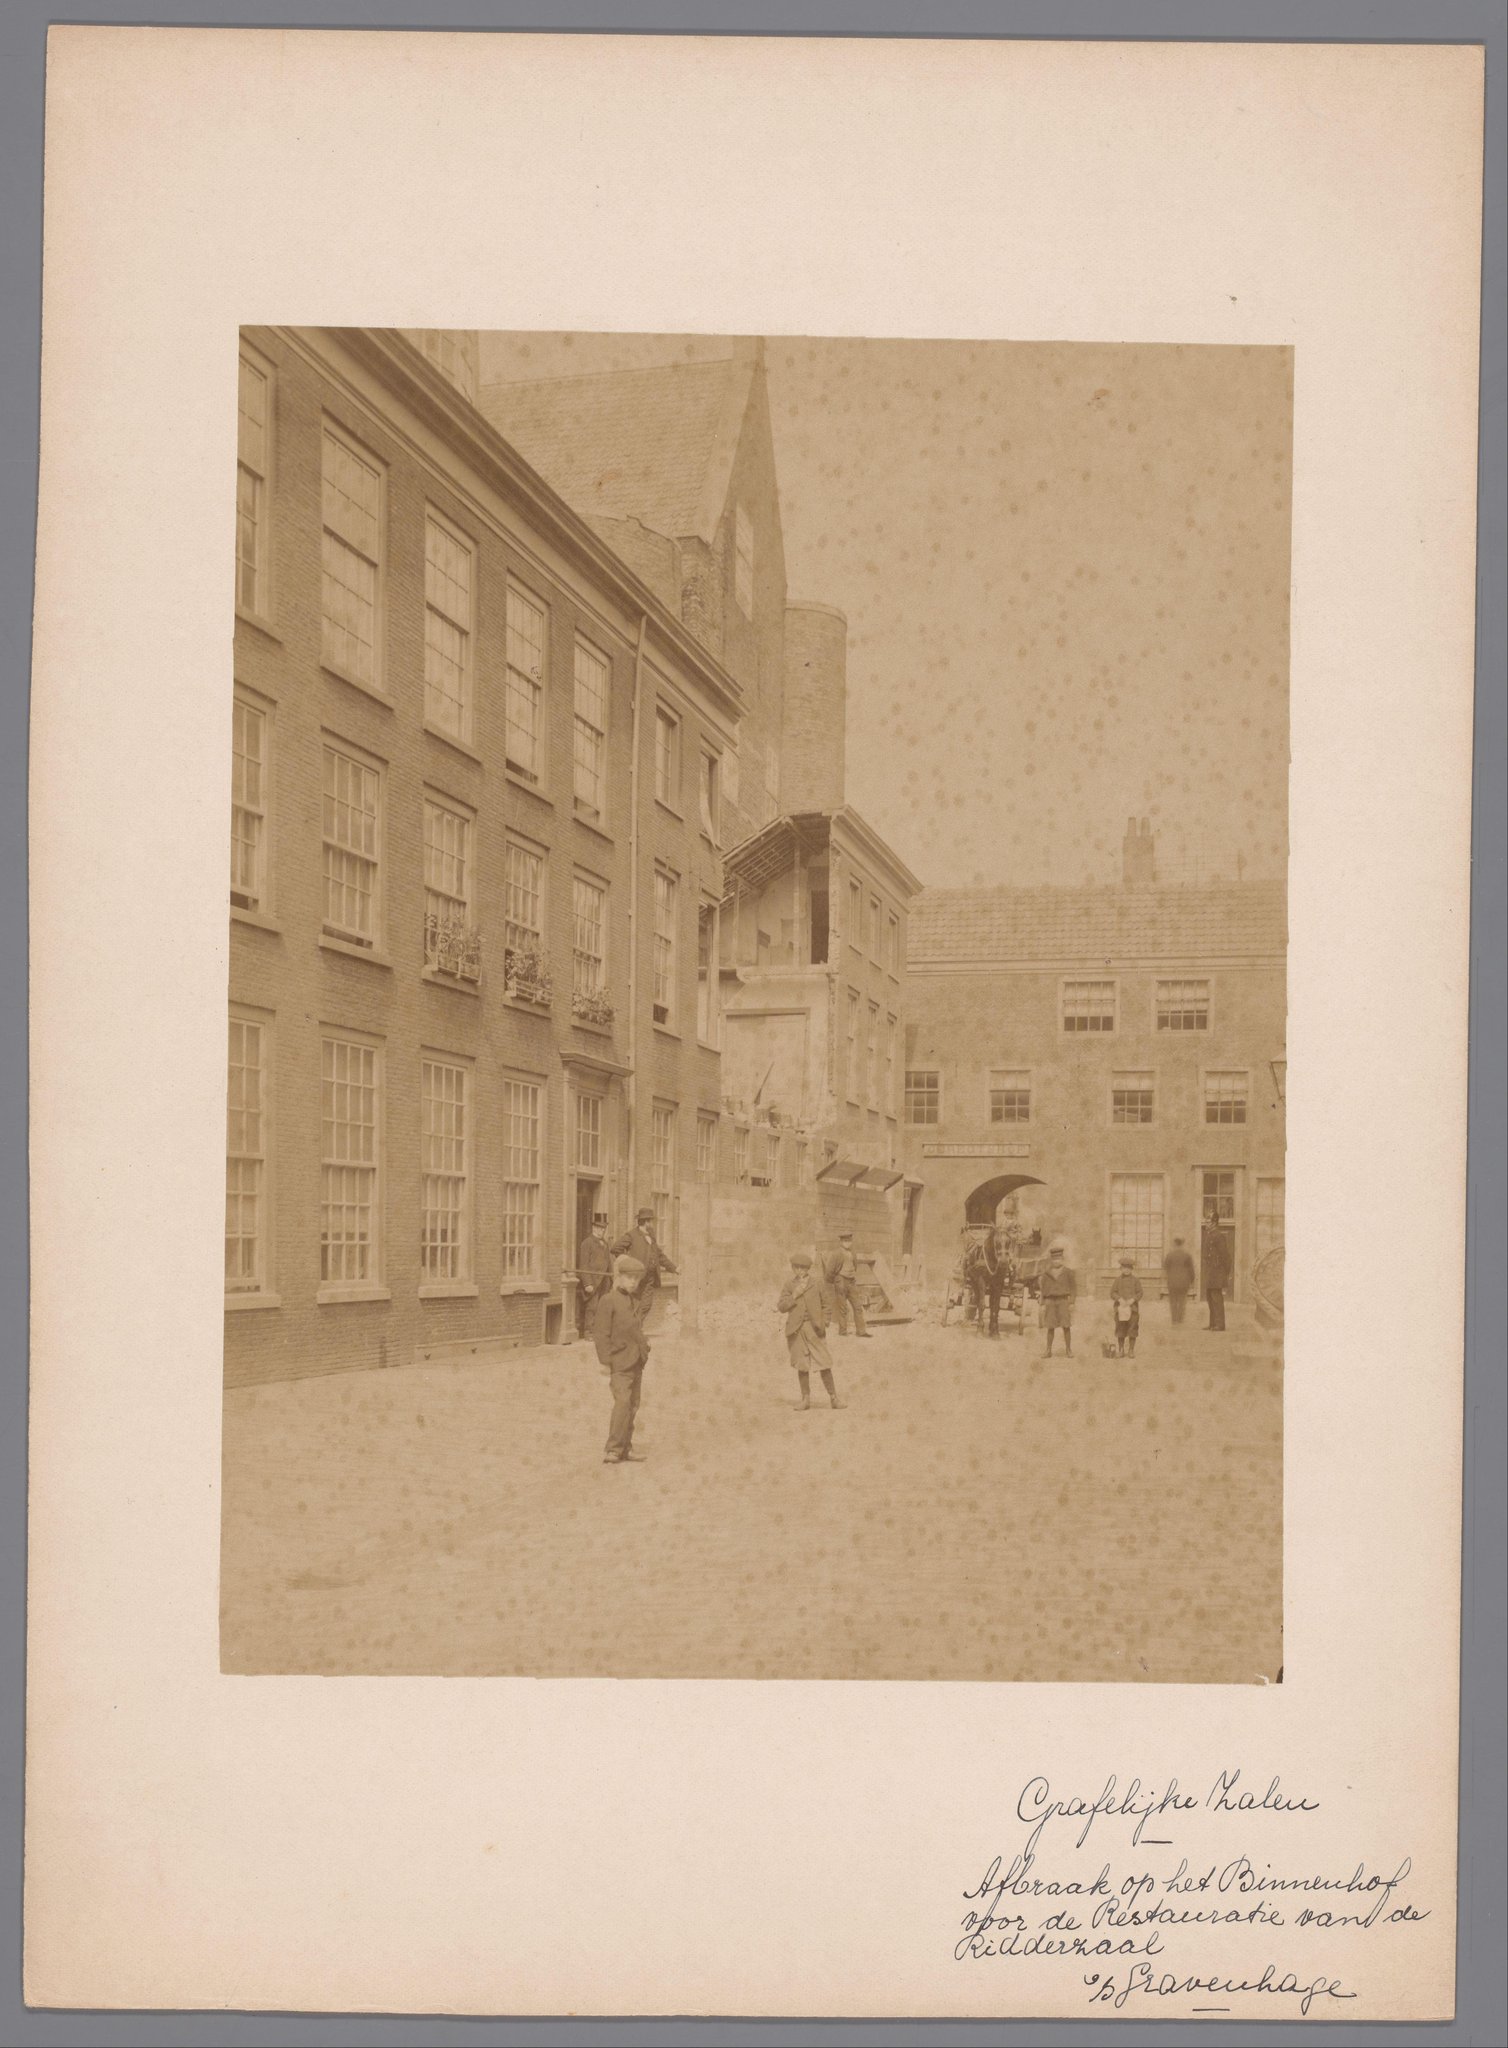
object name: photograph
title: Gezicht op gebouwen aan het Binnenhof tijdens de restauratie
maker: anoniem (monumentenzorg)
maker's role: fotograaf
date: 1900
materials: cardboard, photographic support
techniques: albumen print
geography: binnenhof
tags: urban housing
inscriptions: annotation: ‘Grafelijke Zalen/ Afbraak op het Binnenhof voor de restauratie van de Ridderzaal/ 's Gravenhage’, annotation: ‘Haag (Z.H.)/ afbraak op het binnenhof voor de restauratie van de Ridderzaal’